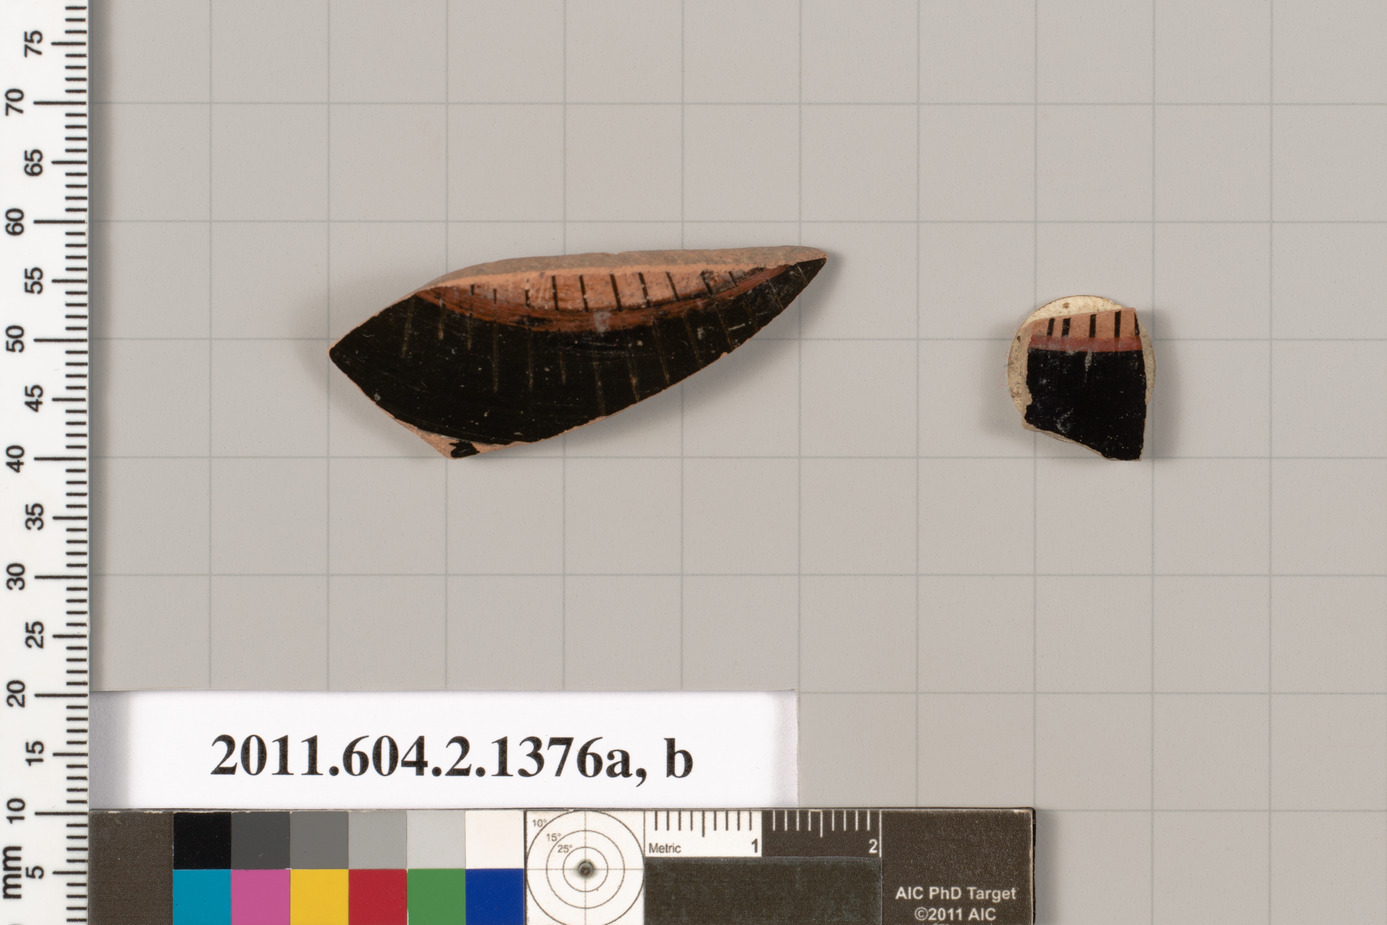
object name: skyphos fragment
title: Terracotta fragments of skyphoi (deep drinking cups)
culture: greek, attic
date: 475-451 BCE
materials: terracotta